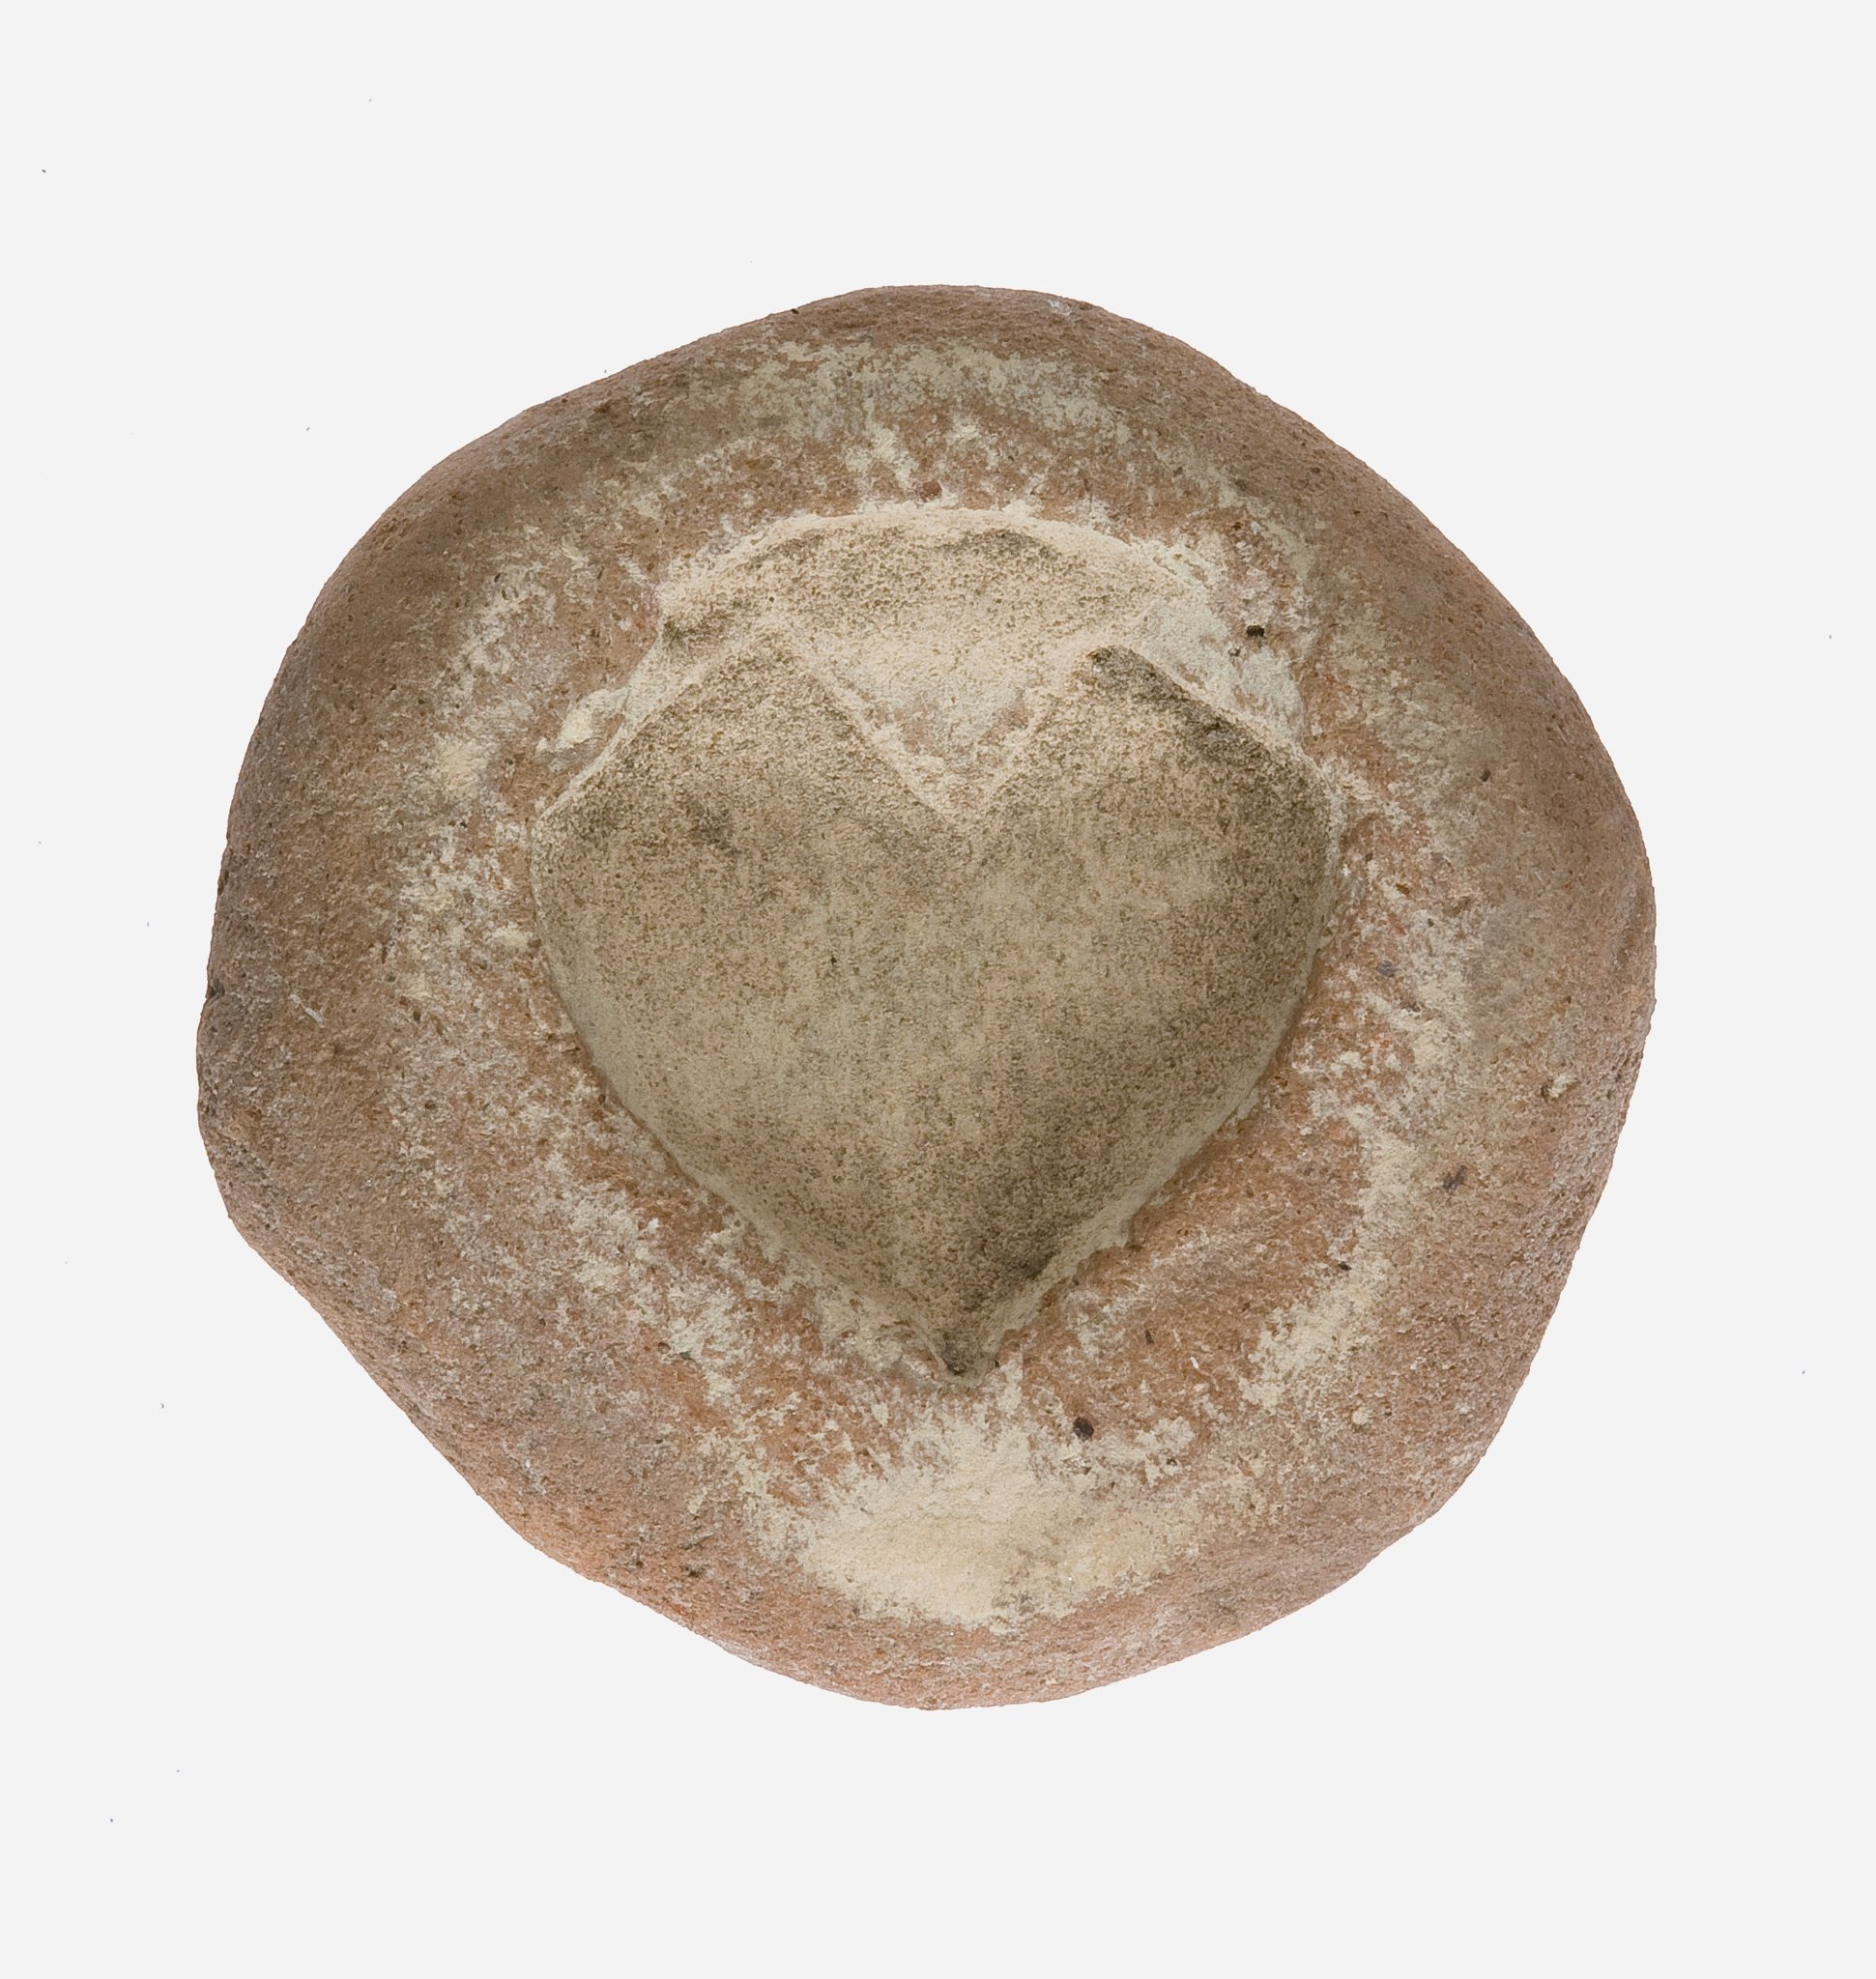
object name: mold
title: Persia Fruit Mold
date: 1390-1352 BCE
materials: pottery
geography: egypt